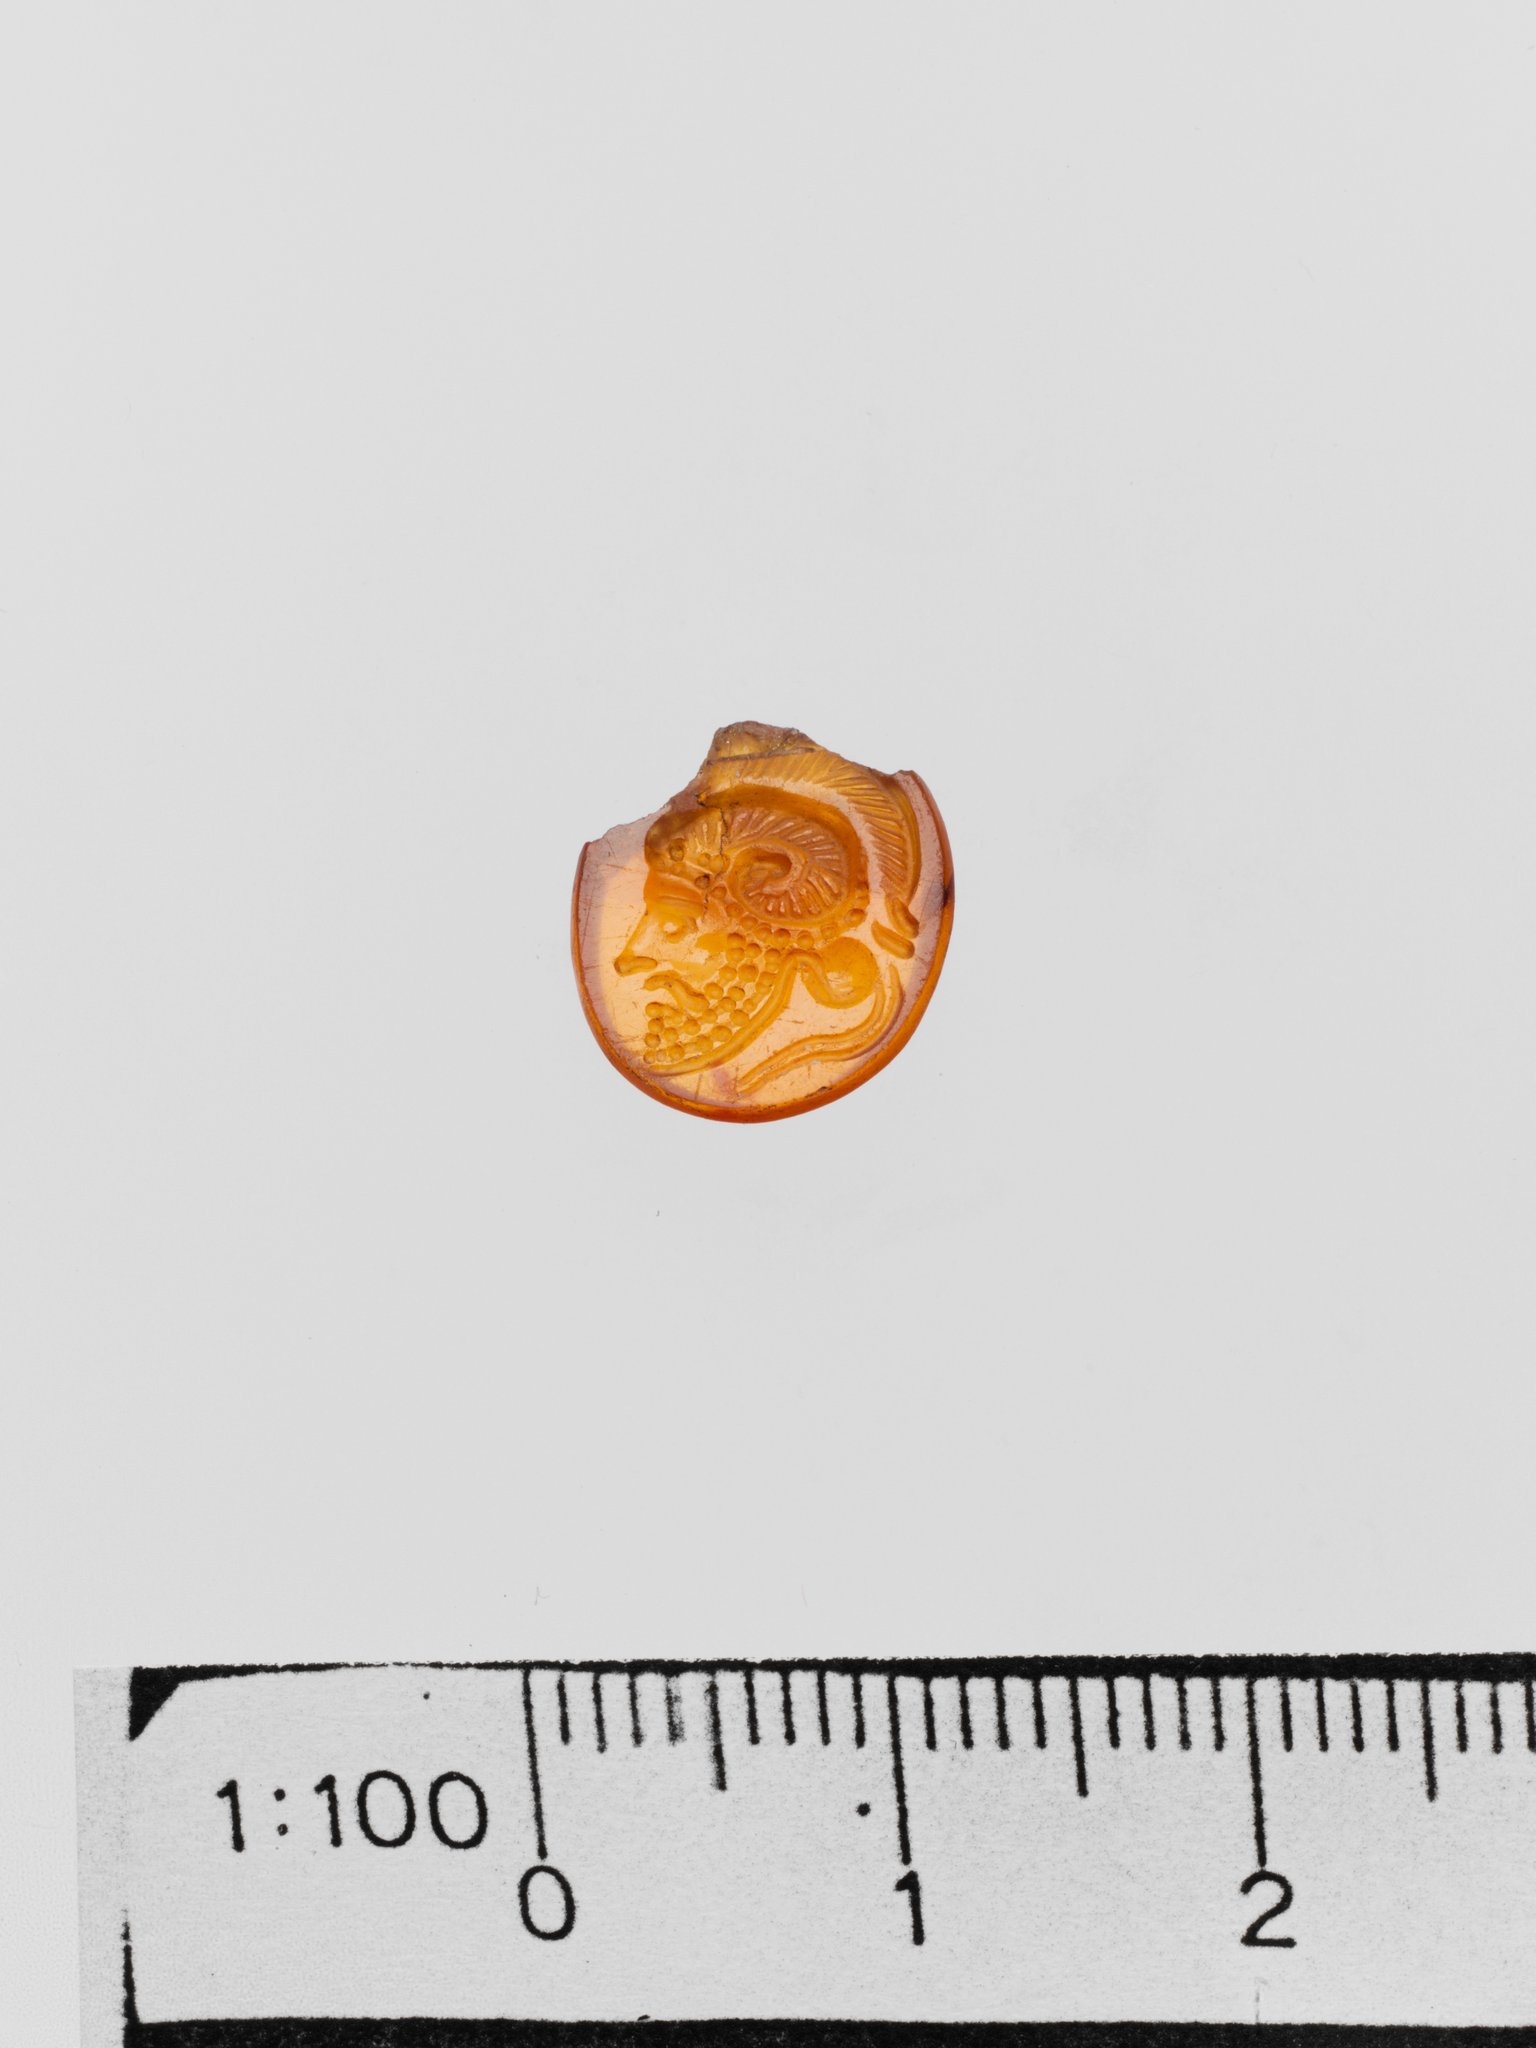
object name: intaglio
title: Sard ring stone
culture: italic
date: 300-101 BCE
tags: heads,men